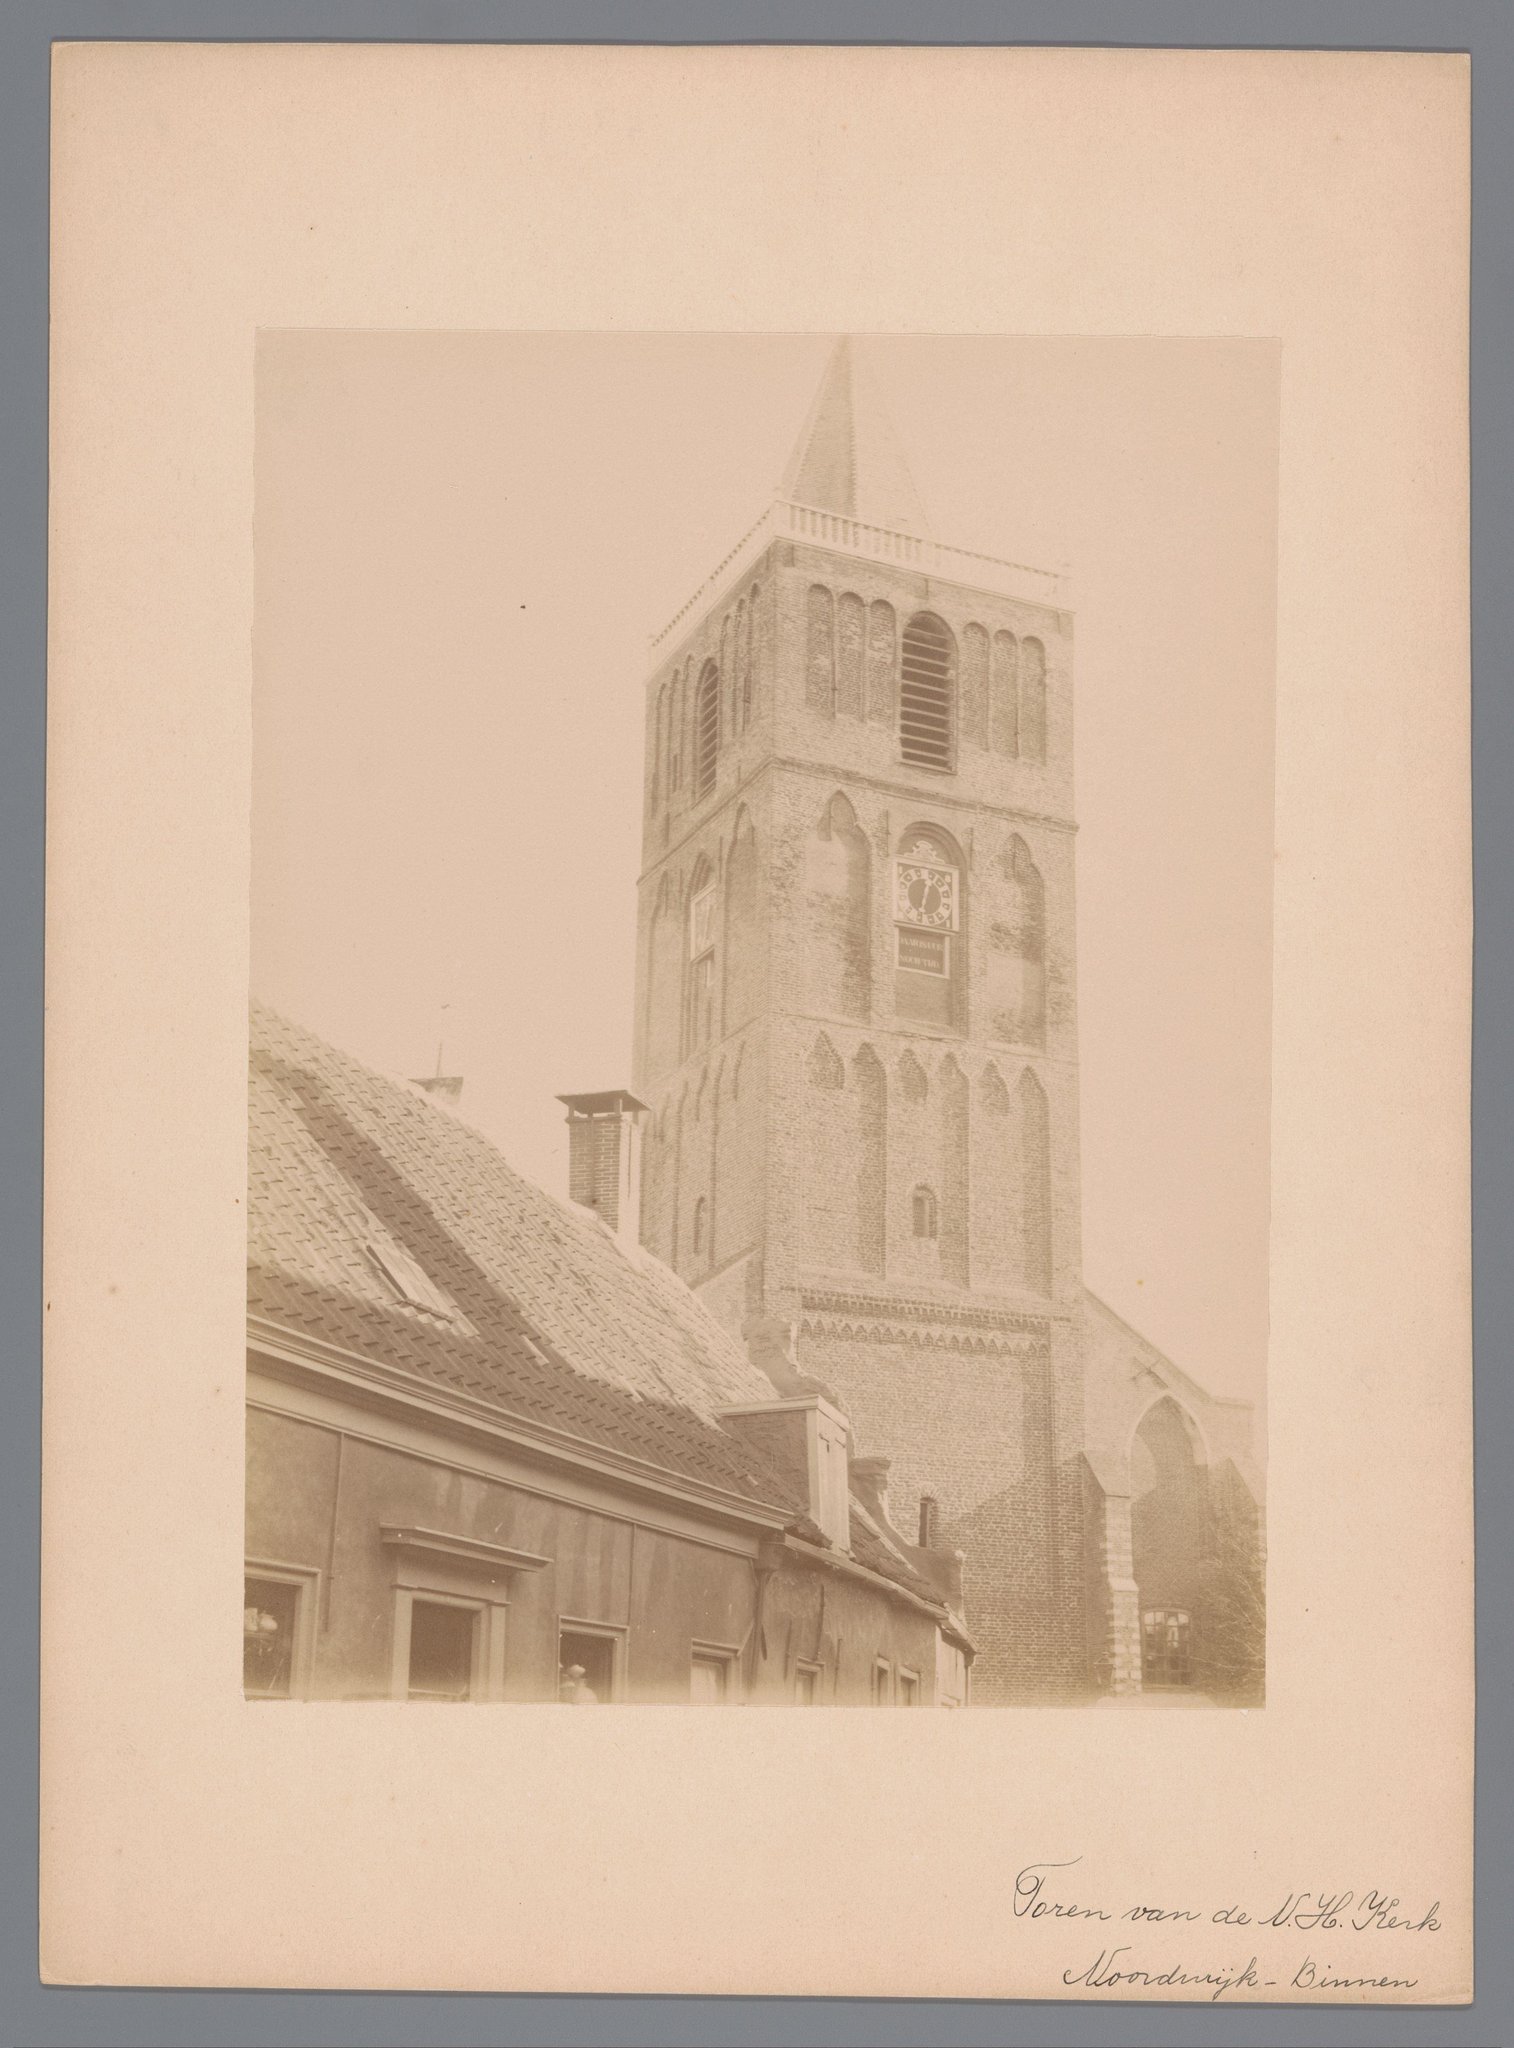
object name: photograph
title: Toren van de Hervormde Kerk te Noordwijk-Binnen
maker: anoniem (monumentenzorg)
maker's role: fotograaf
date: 1890-1920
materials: cardboard, photographic support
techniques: albumen print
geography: noordwijk-binnen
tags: parts of church exterior and annexes: tower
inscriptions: annotation: ‘Toren v/d Ned. Herv. Kerk te Noordwijk’, annotation: ‘Toren van de N.H. Kerk/ Noordwijk-Binnen’